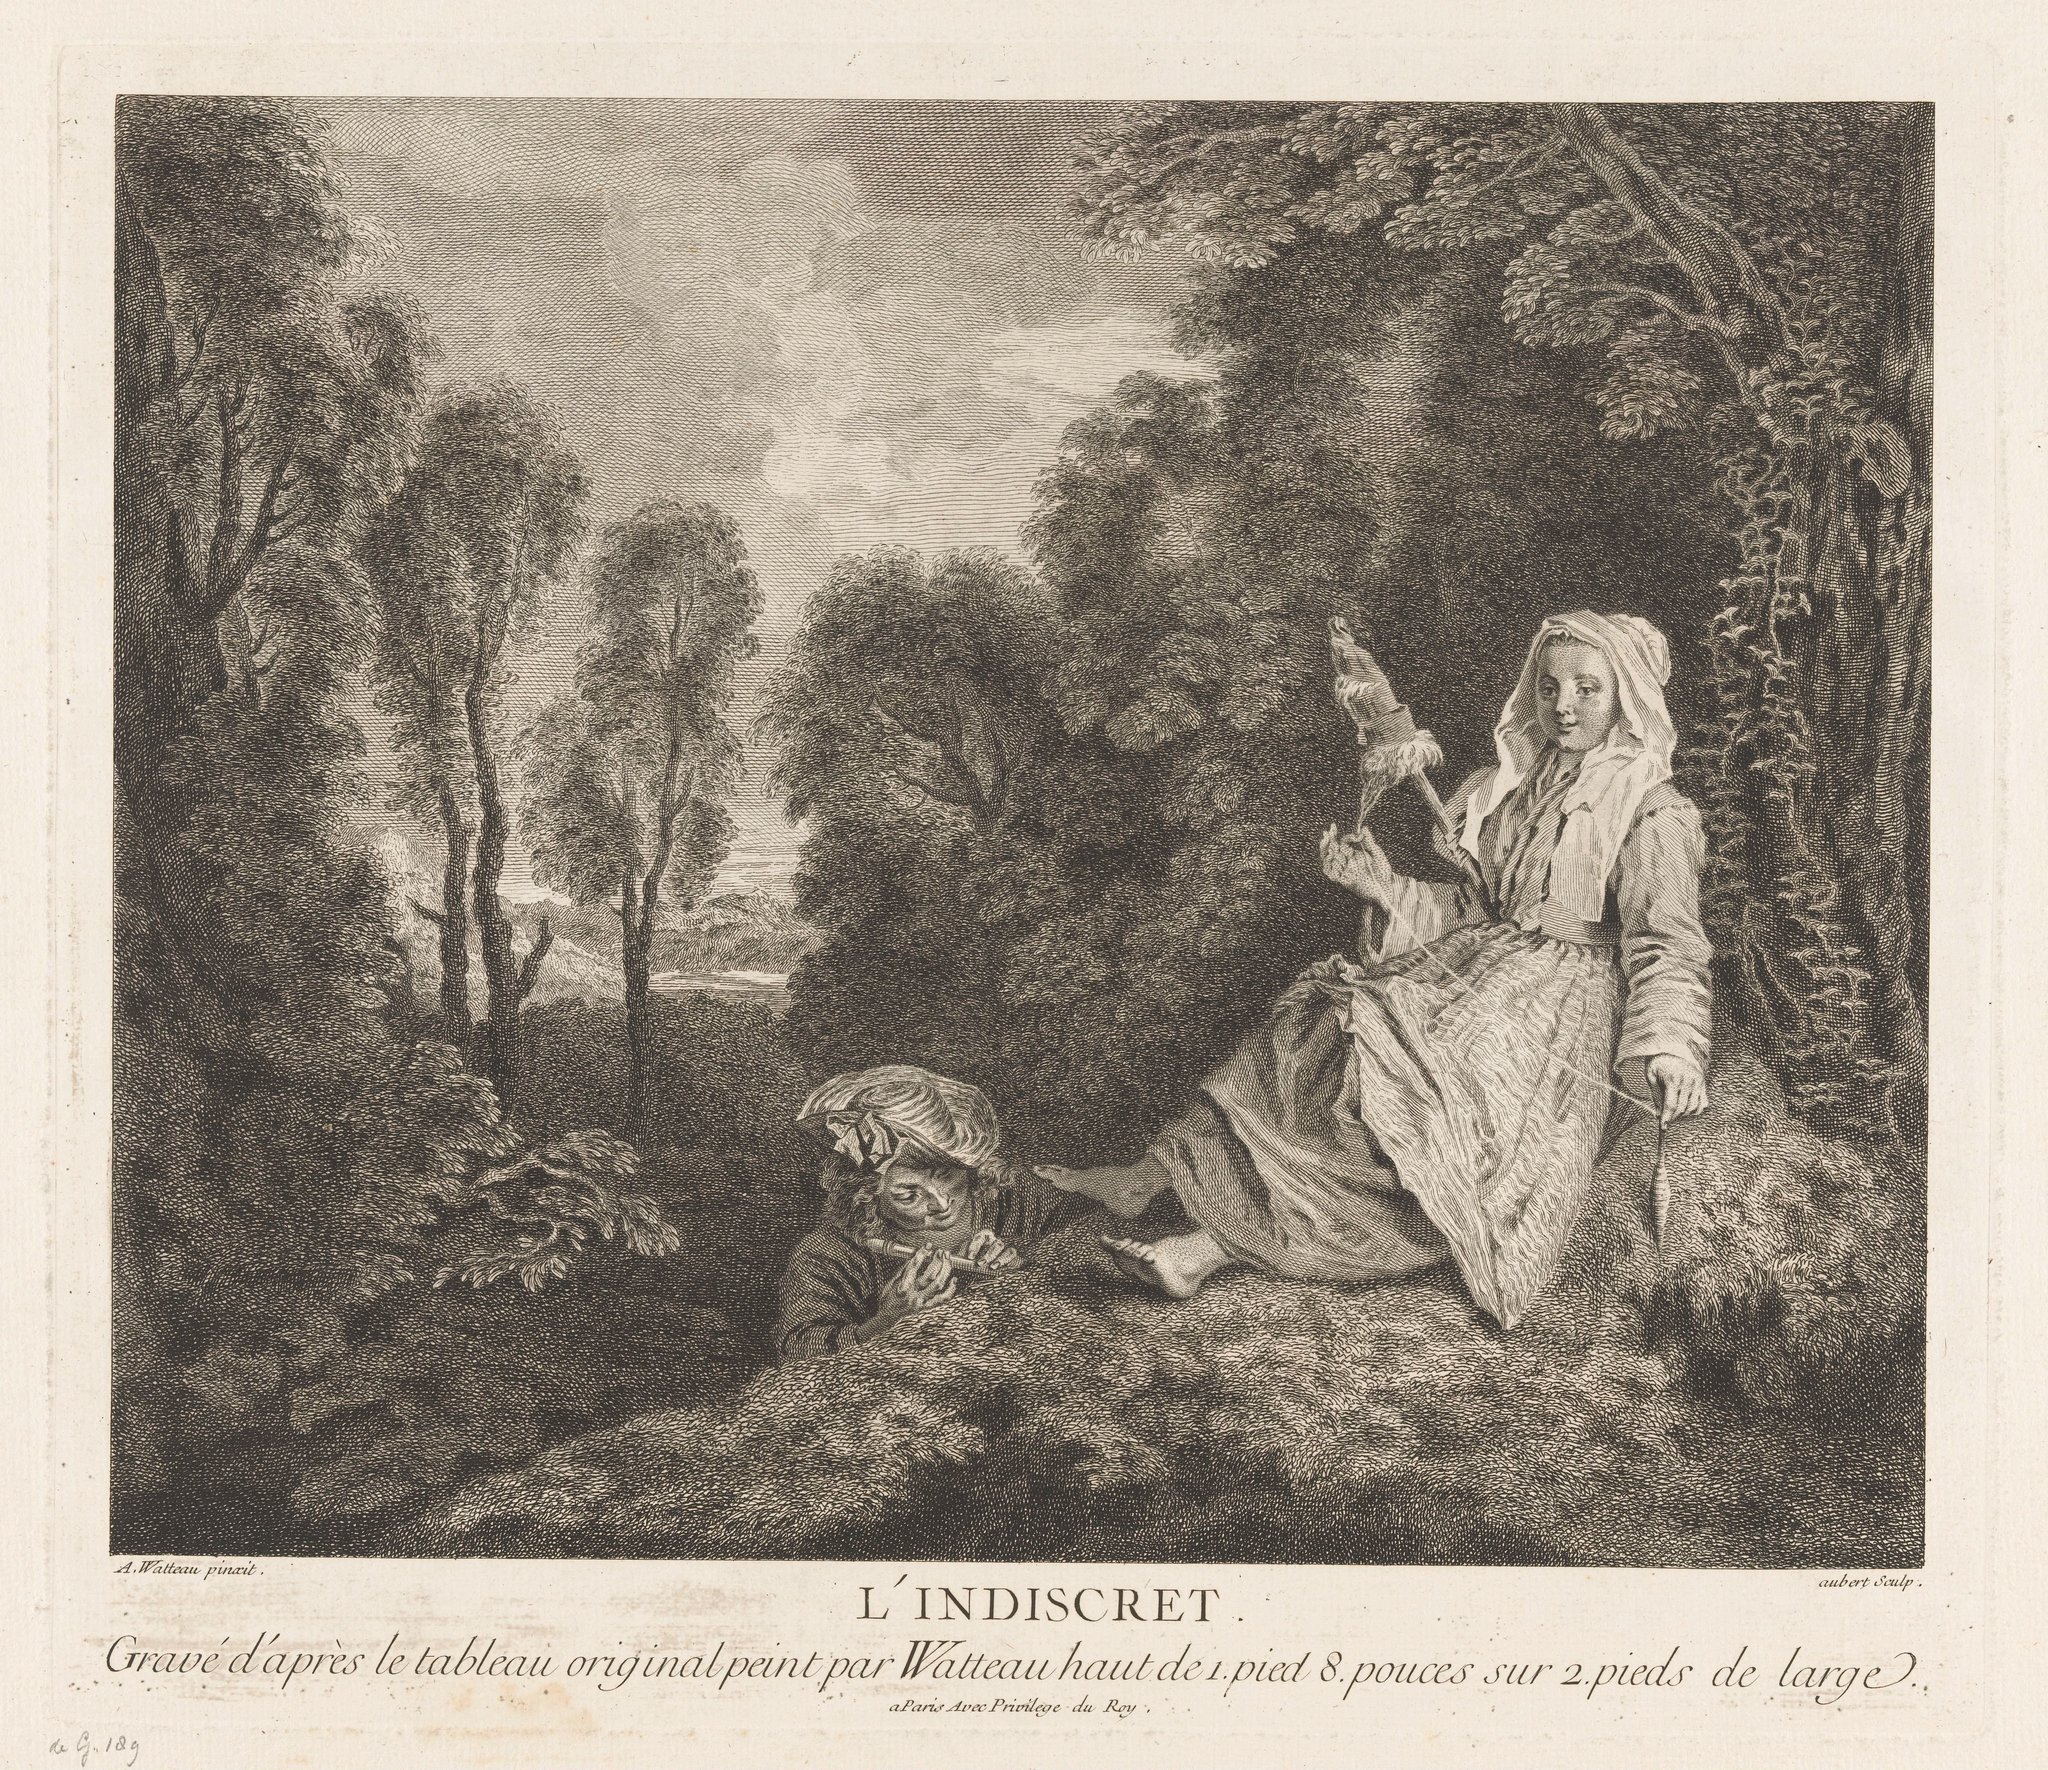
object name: print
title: Man met fluit en vrouw met spoel in een landschap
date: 1710-1757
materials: paper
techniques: engraving, etching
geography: france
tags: sitting figure - aa - female human figure, spindle, forest, wood, flute, aulos, tibia